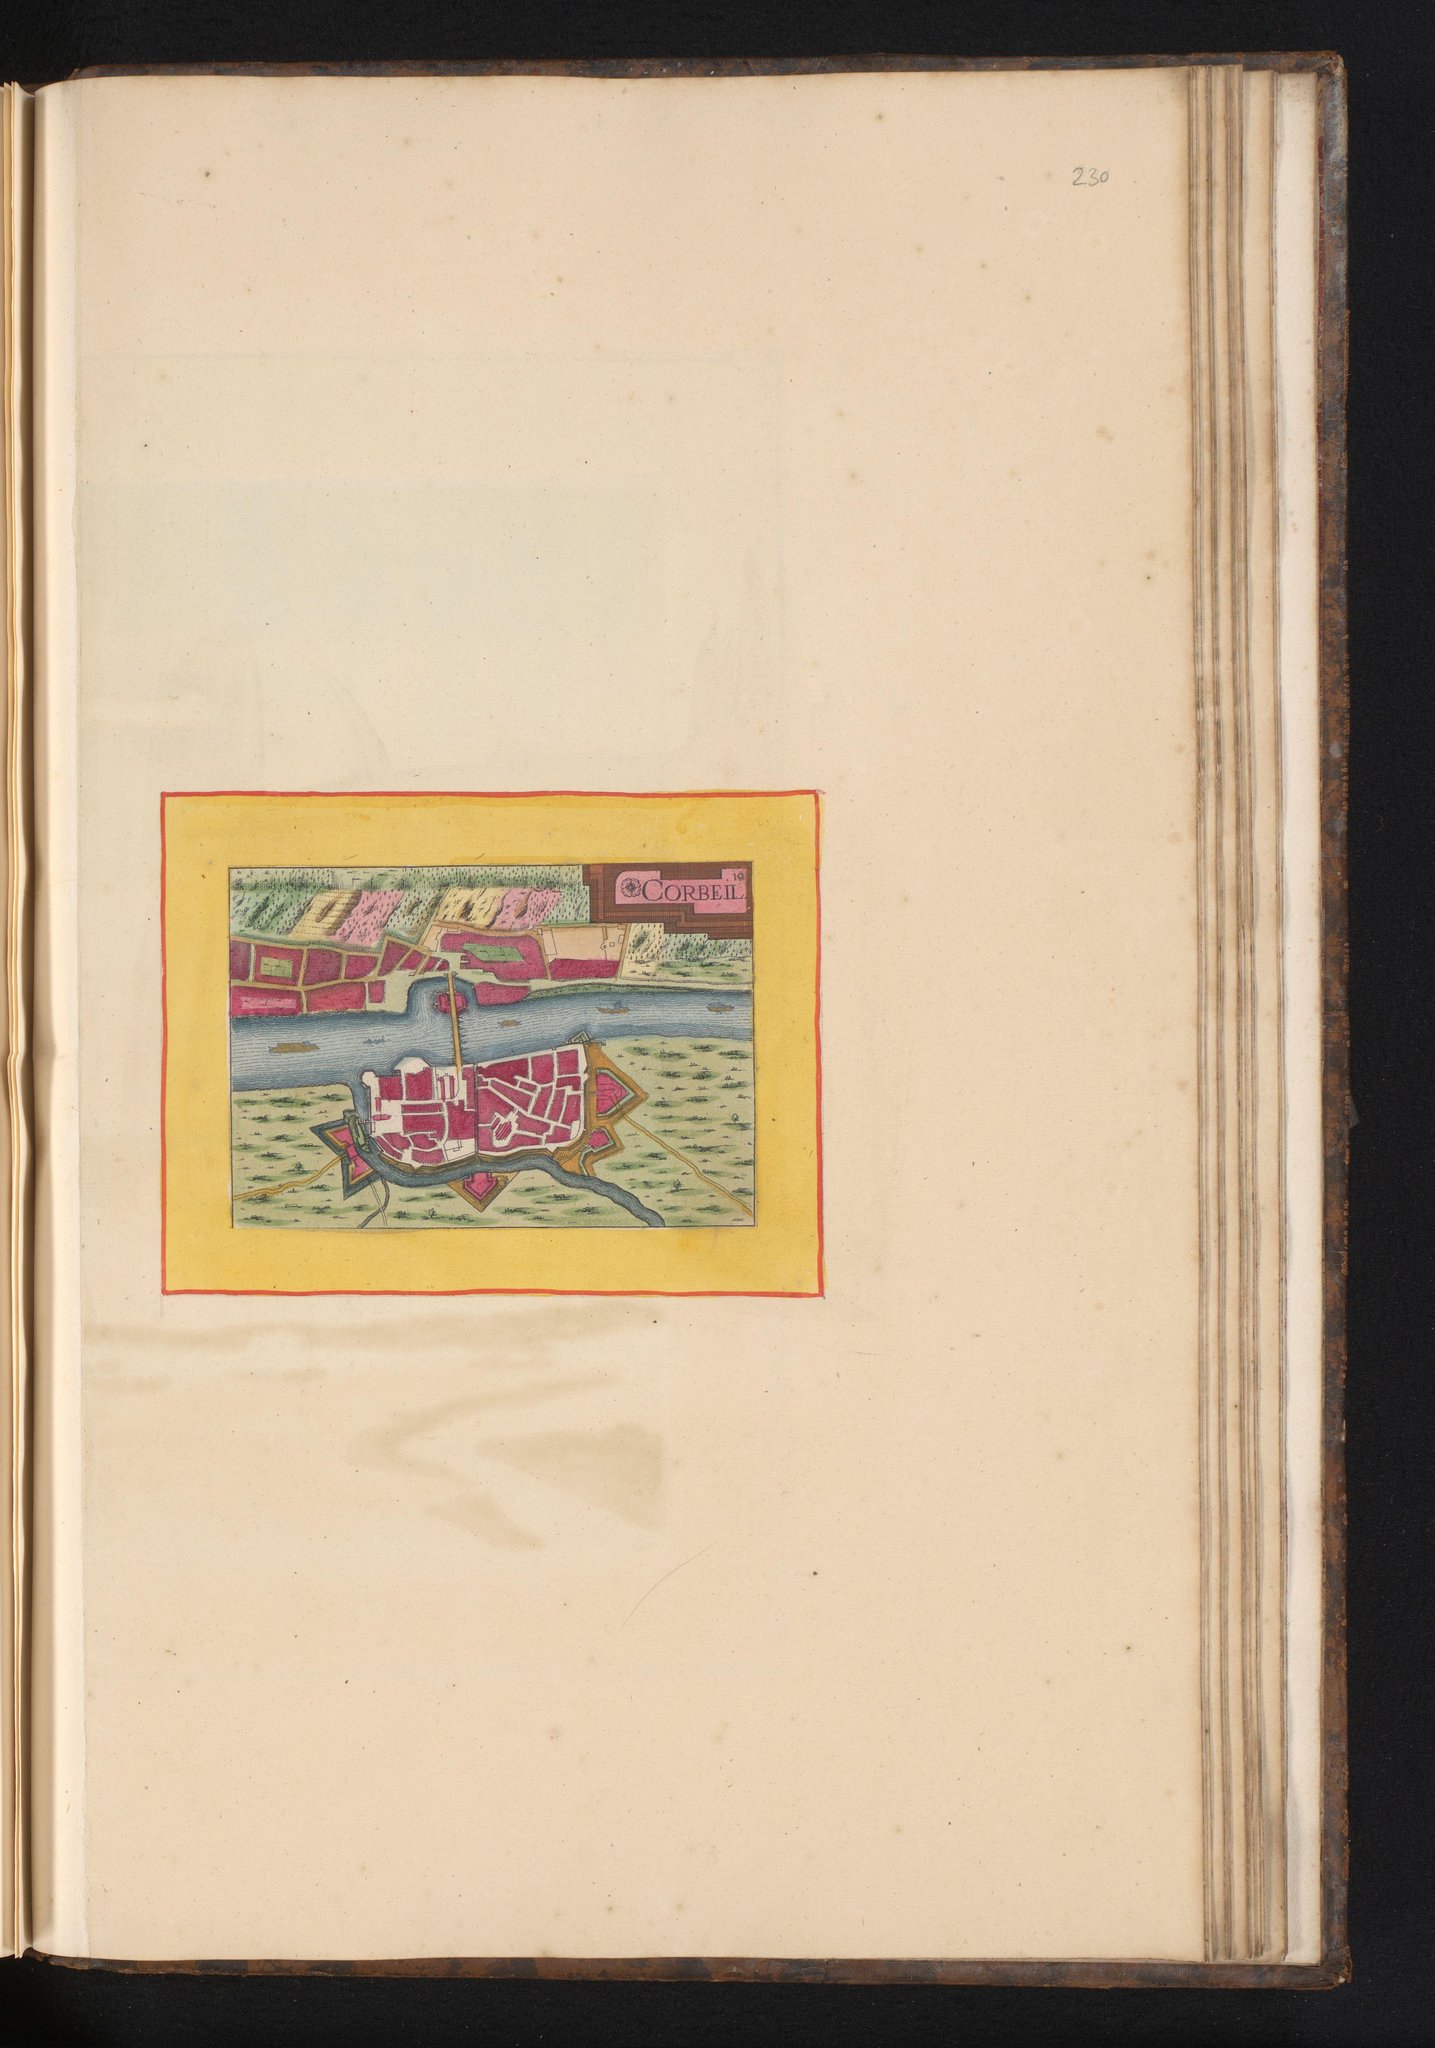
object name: map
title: Kaart van de stad Corbeil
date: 1634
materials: paper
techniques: etching, hand coloring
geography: the hague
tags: maps of cities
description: Prent origineel vervaardigd als boekillustratie voor: Tassin, Christophe. Les plans et profils de toutes les principales villes et lieux considerables de France. 1634.